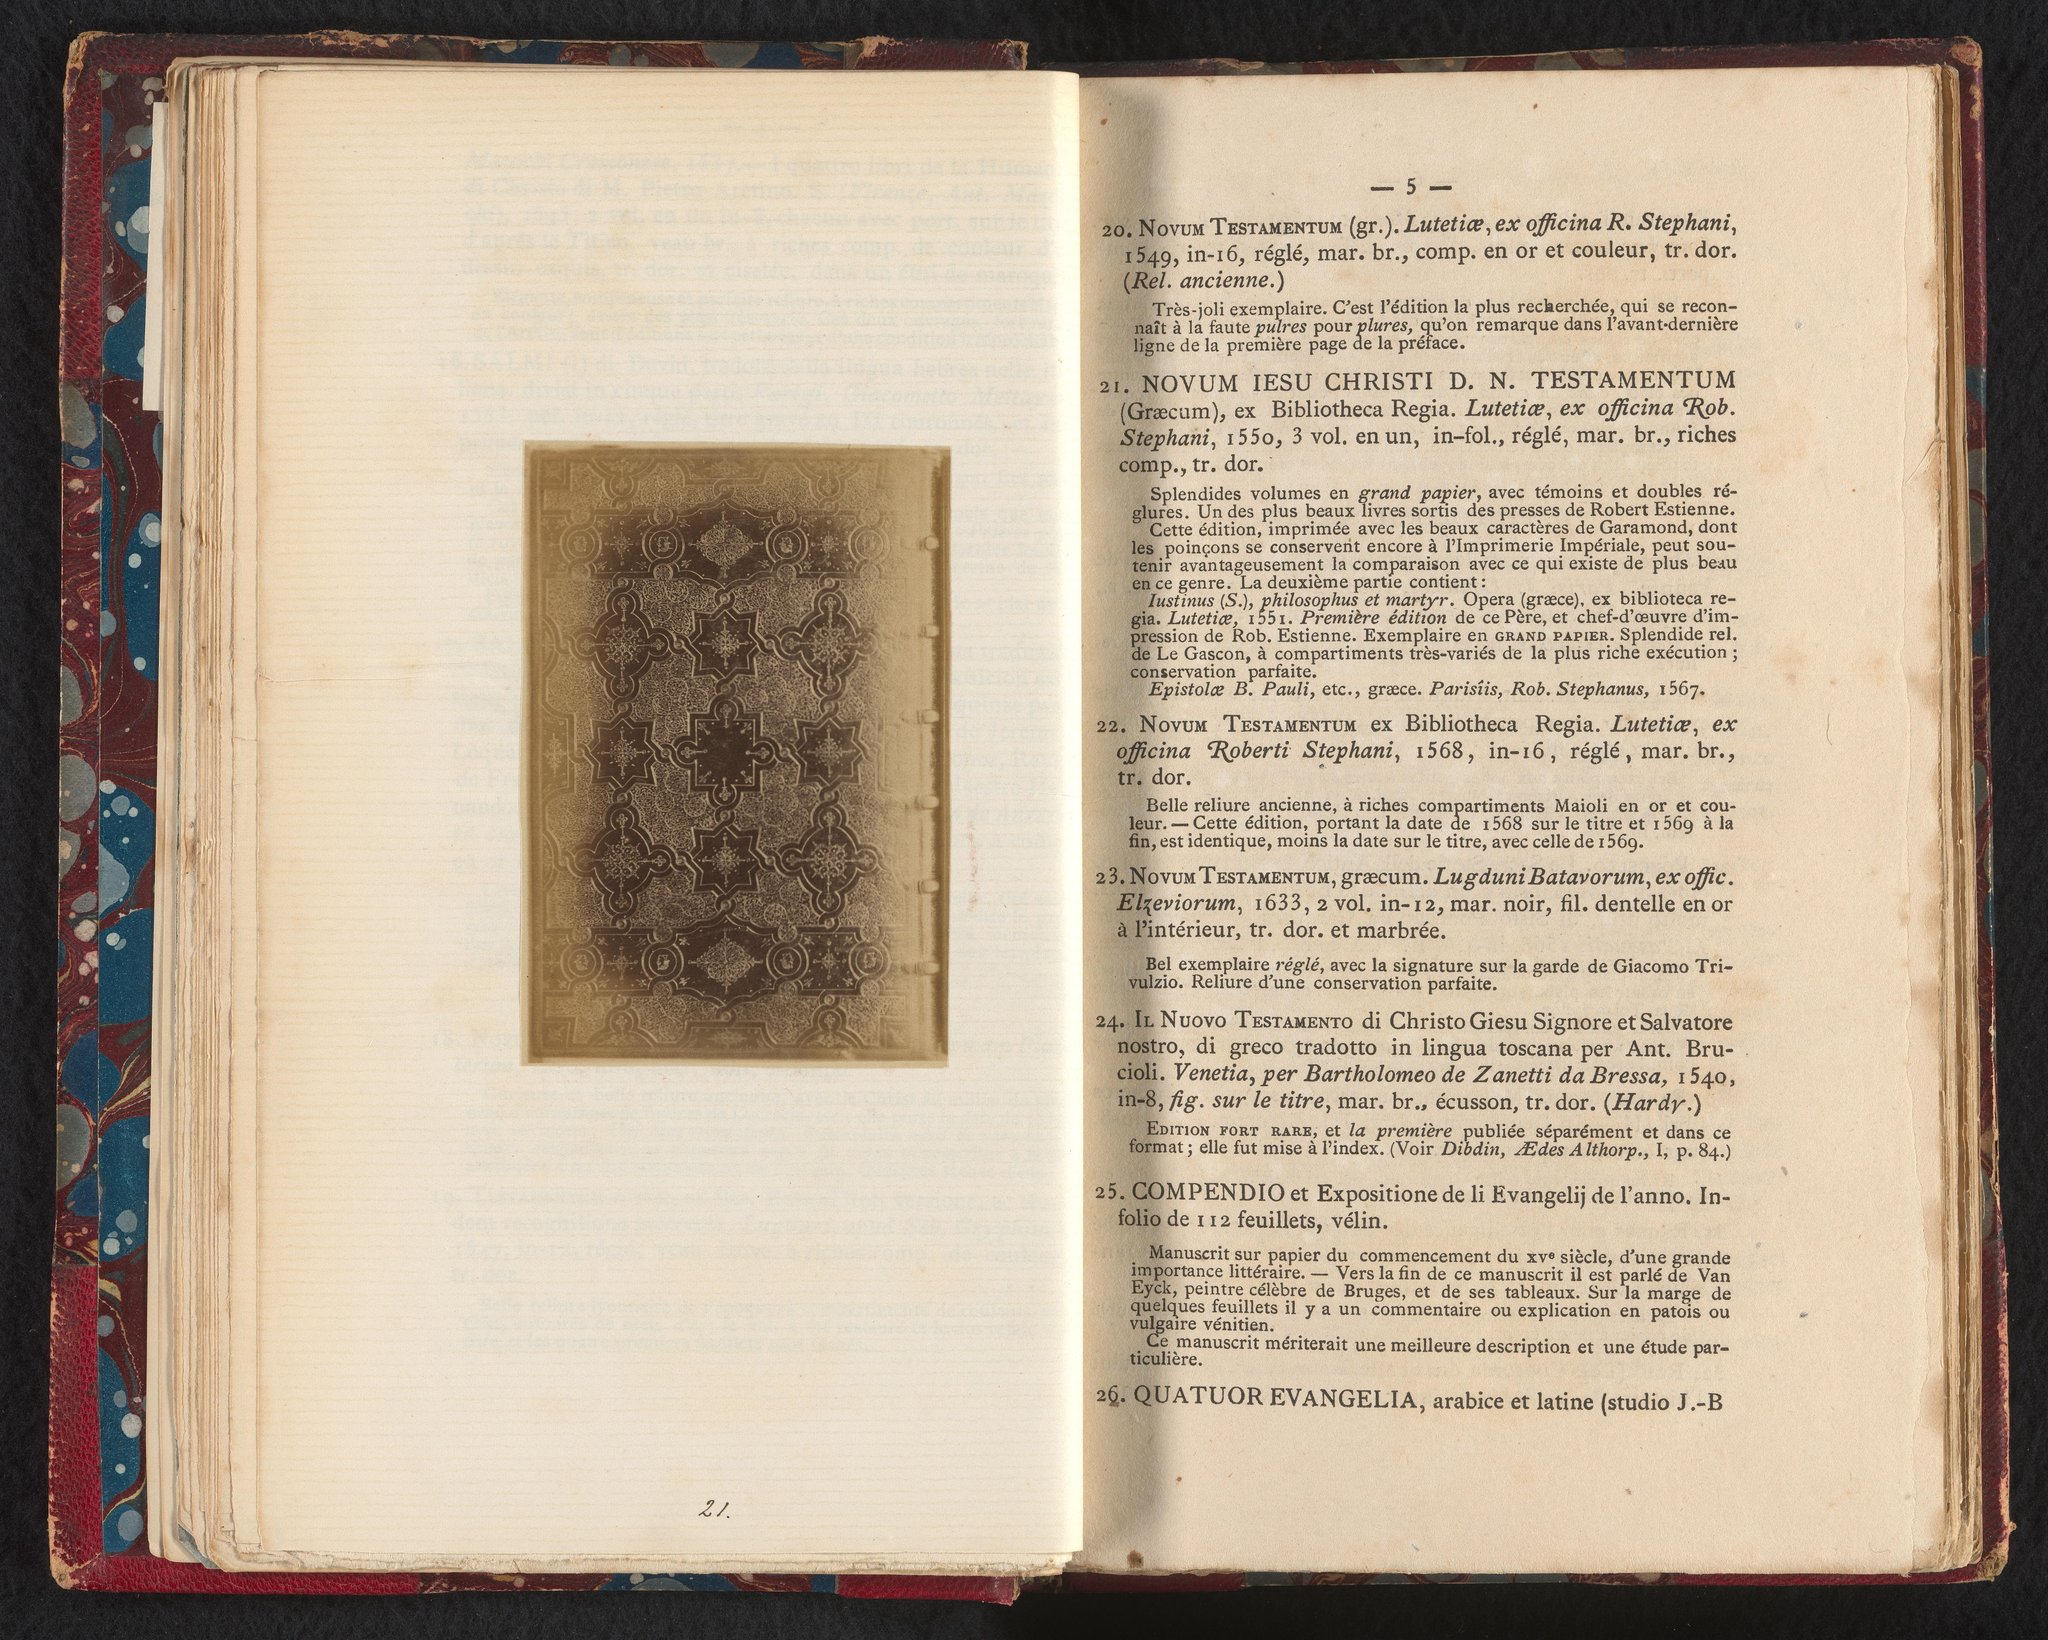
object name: page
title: Fotoreproductie van boekomslag van Novum Iesu Christi D.N. Testamentum (...) uit 1550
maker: Anonymous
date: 1863-1868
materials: paper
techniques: albumen print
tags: book-cover, binding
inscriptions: number: ‘21’